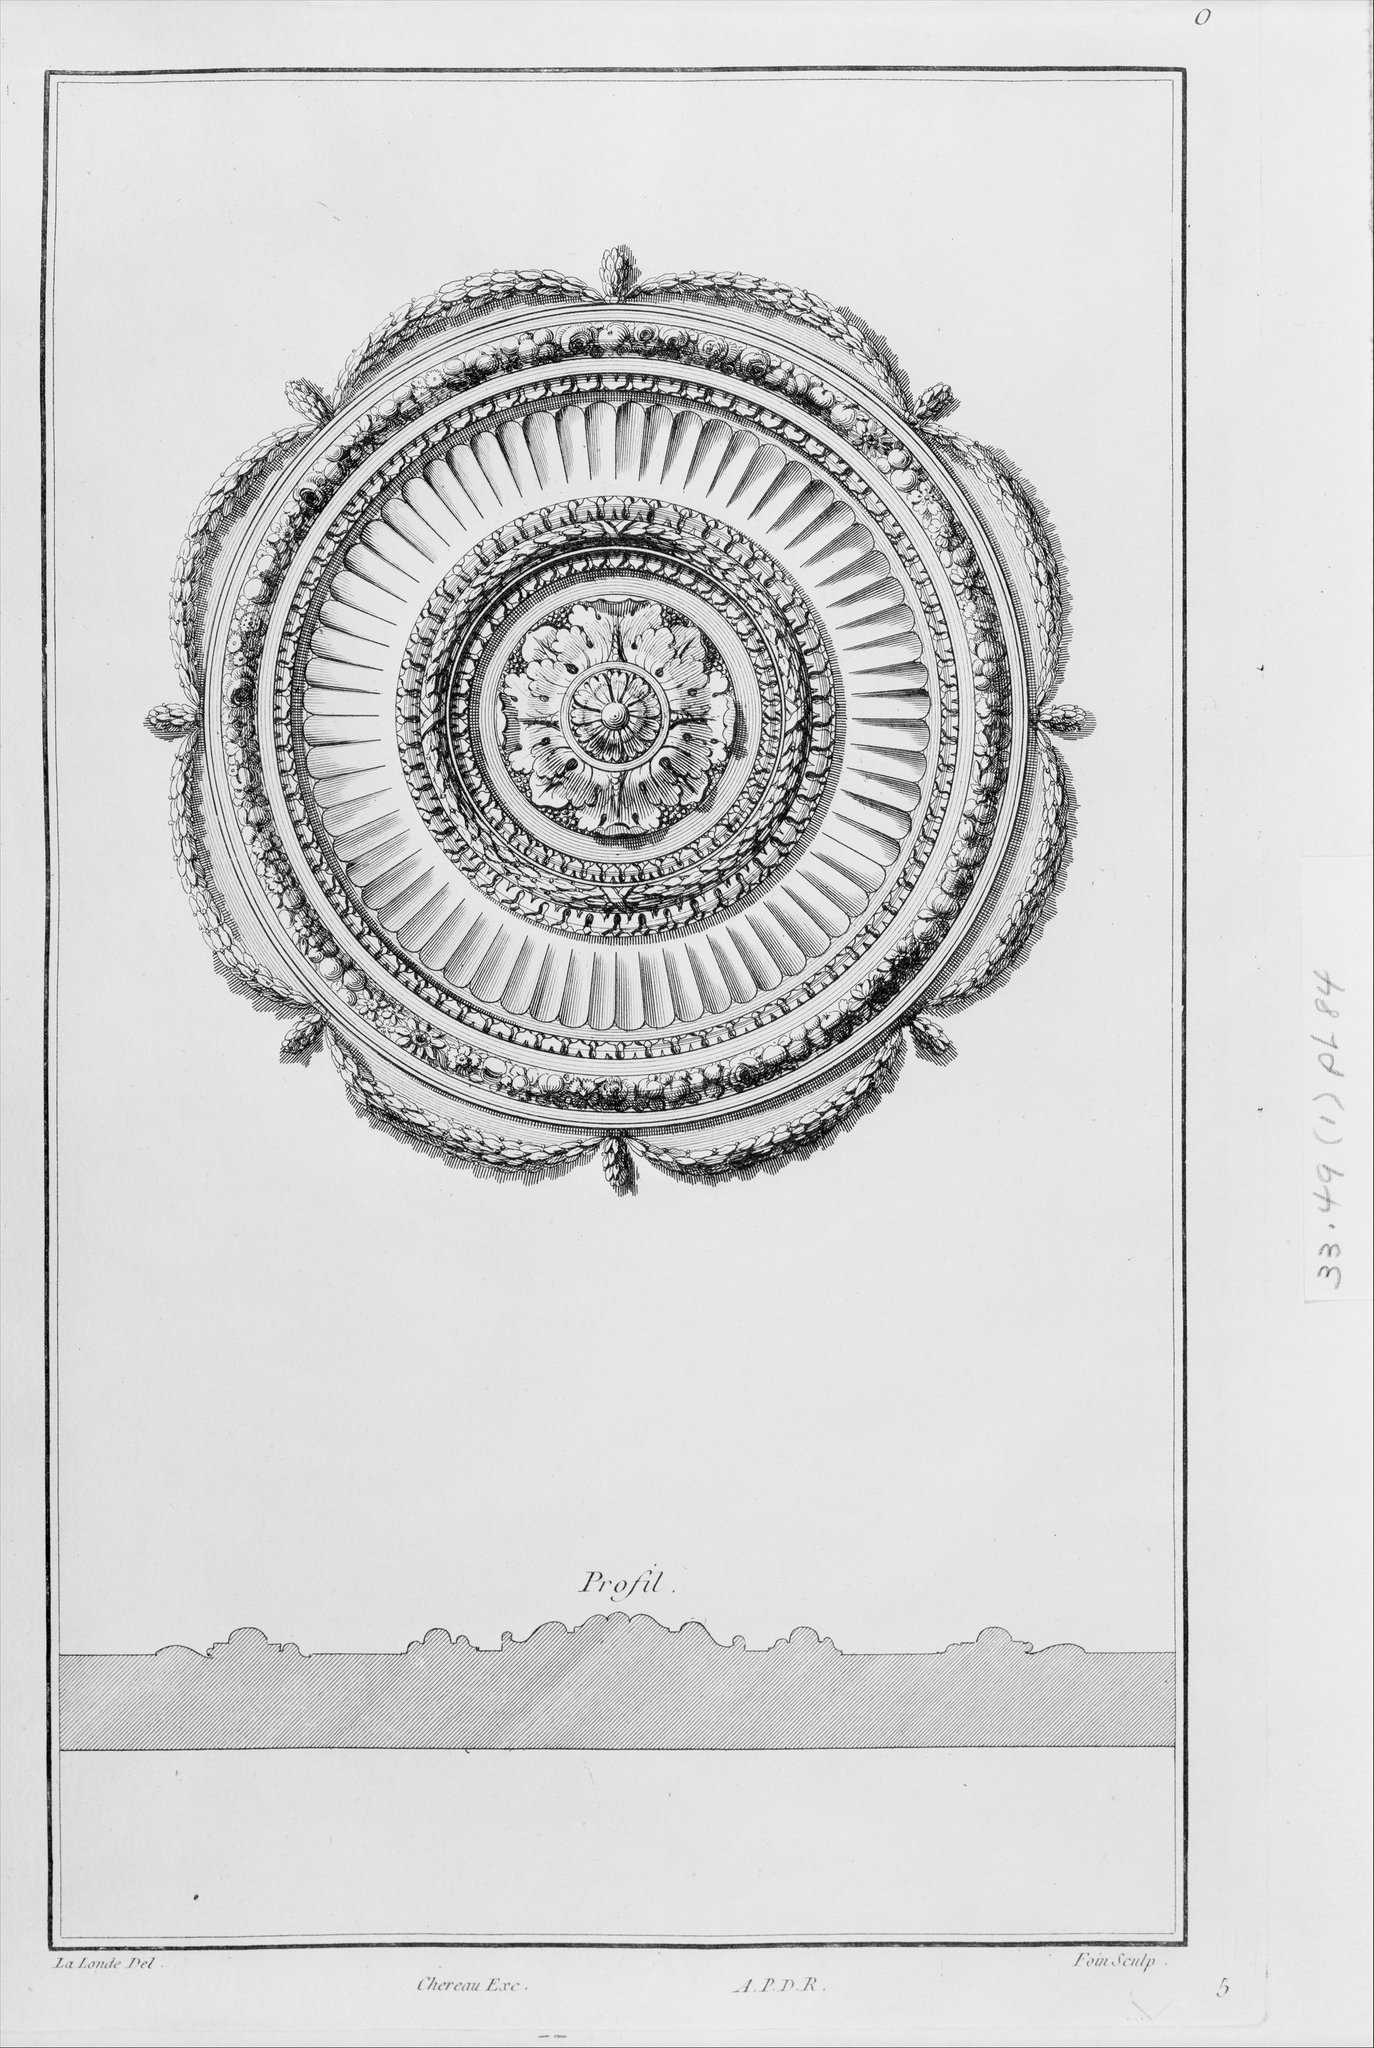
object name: book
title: Oeuvres Diverses de Lalonde. Tome 1.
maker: richard de lalonde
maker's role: artist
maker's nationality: french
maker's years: 1780-1790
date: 1767-1800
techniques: engraving, etching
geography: france